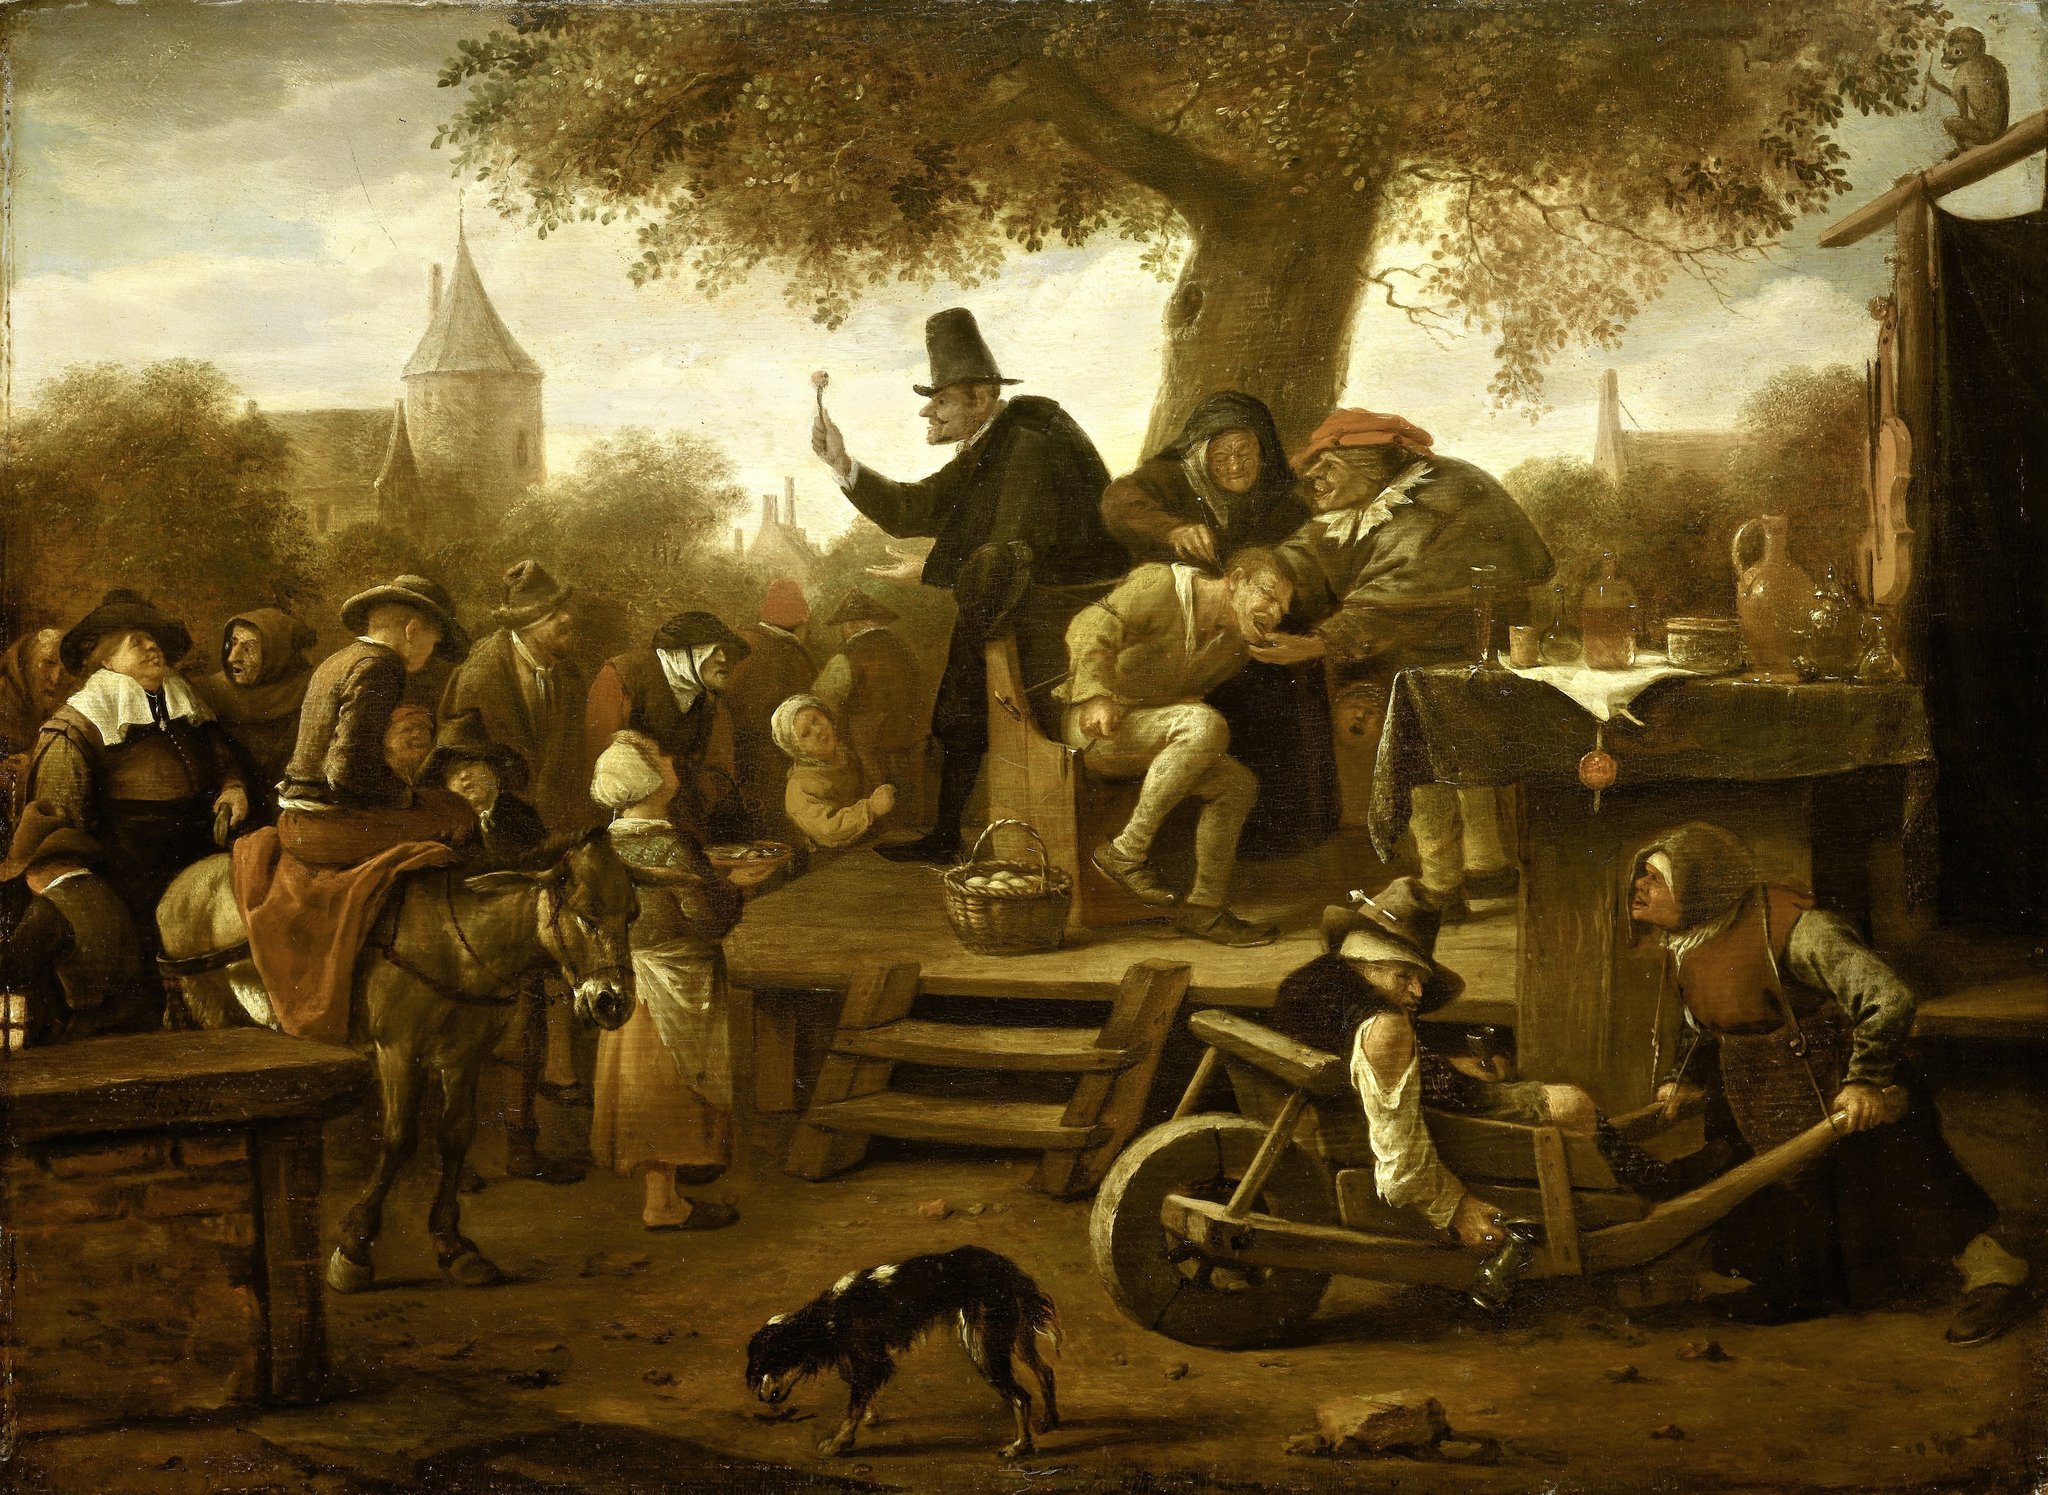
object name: painting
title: The quack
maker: jan havicksz. steen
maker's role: painter, print maker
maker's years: 1625-1679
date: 1650-1660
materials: oil, panel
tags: monkeys, apes, animals acting as human beings, pipe ~ tobacco, wheelbarrow, dog, quack extracting teeth or molars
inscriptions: signature: ‘JSteen’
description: De kwakzalver. Op een dorpsplein staat een kwakzalver op een verhoging onder een grote boom, hij toont de dorpelingen de kies (of steen) die hij bij een op een stoel vastgebonden man heeft getrokken. Bij de voeten van de man staat een mand met eieren. Op tafel staan allerlei flessen en potjes en een document met een zegel. Rechts op de voorgrond duwt een vrouw haar dronken man in een kruiwagen. Uiterst rechts hangt een viool aan een paal waarop een aap met een pijp zit.